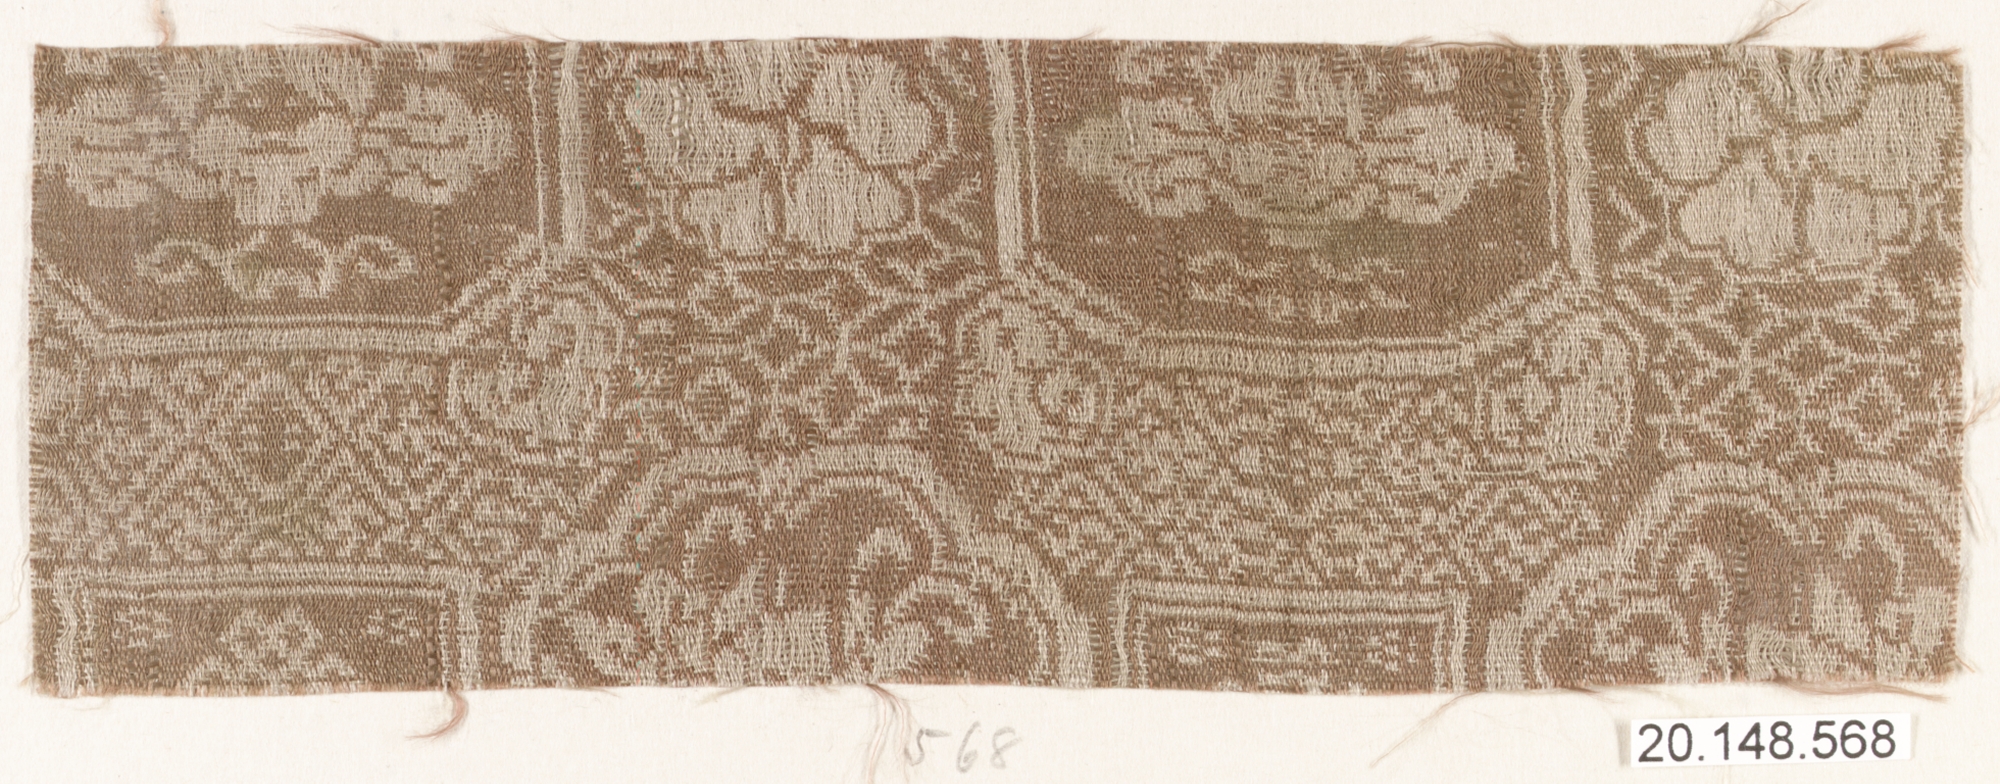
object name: piece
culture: japanese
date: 1701-1800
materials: silk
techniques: compound weave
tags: flowers